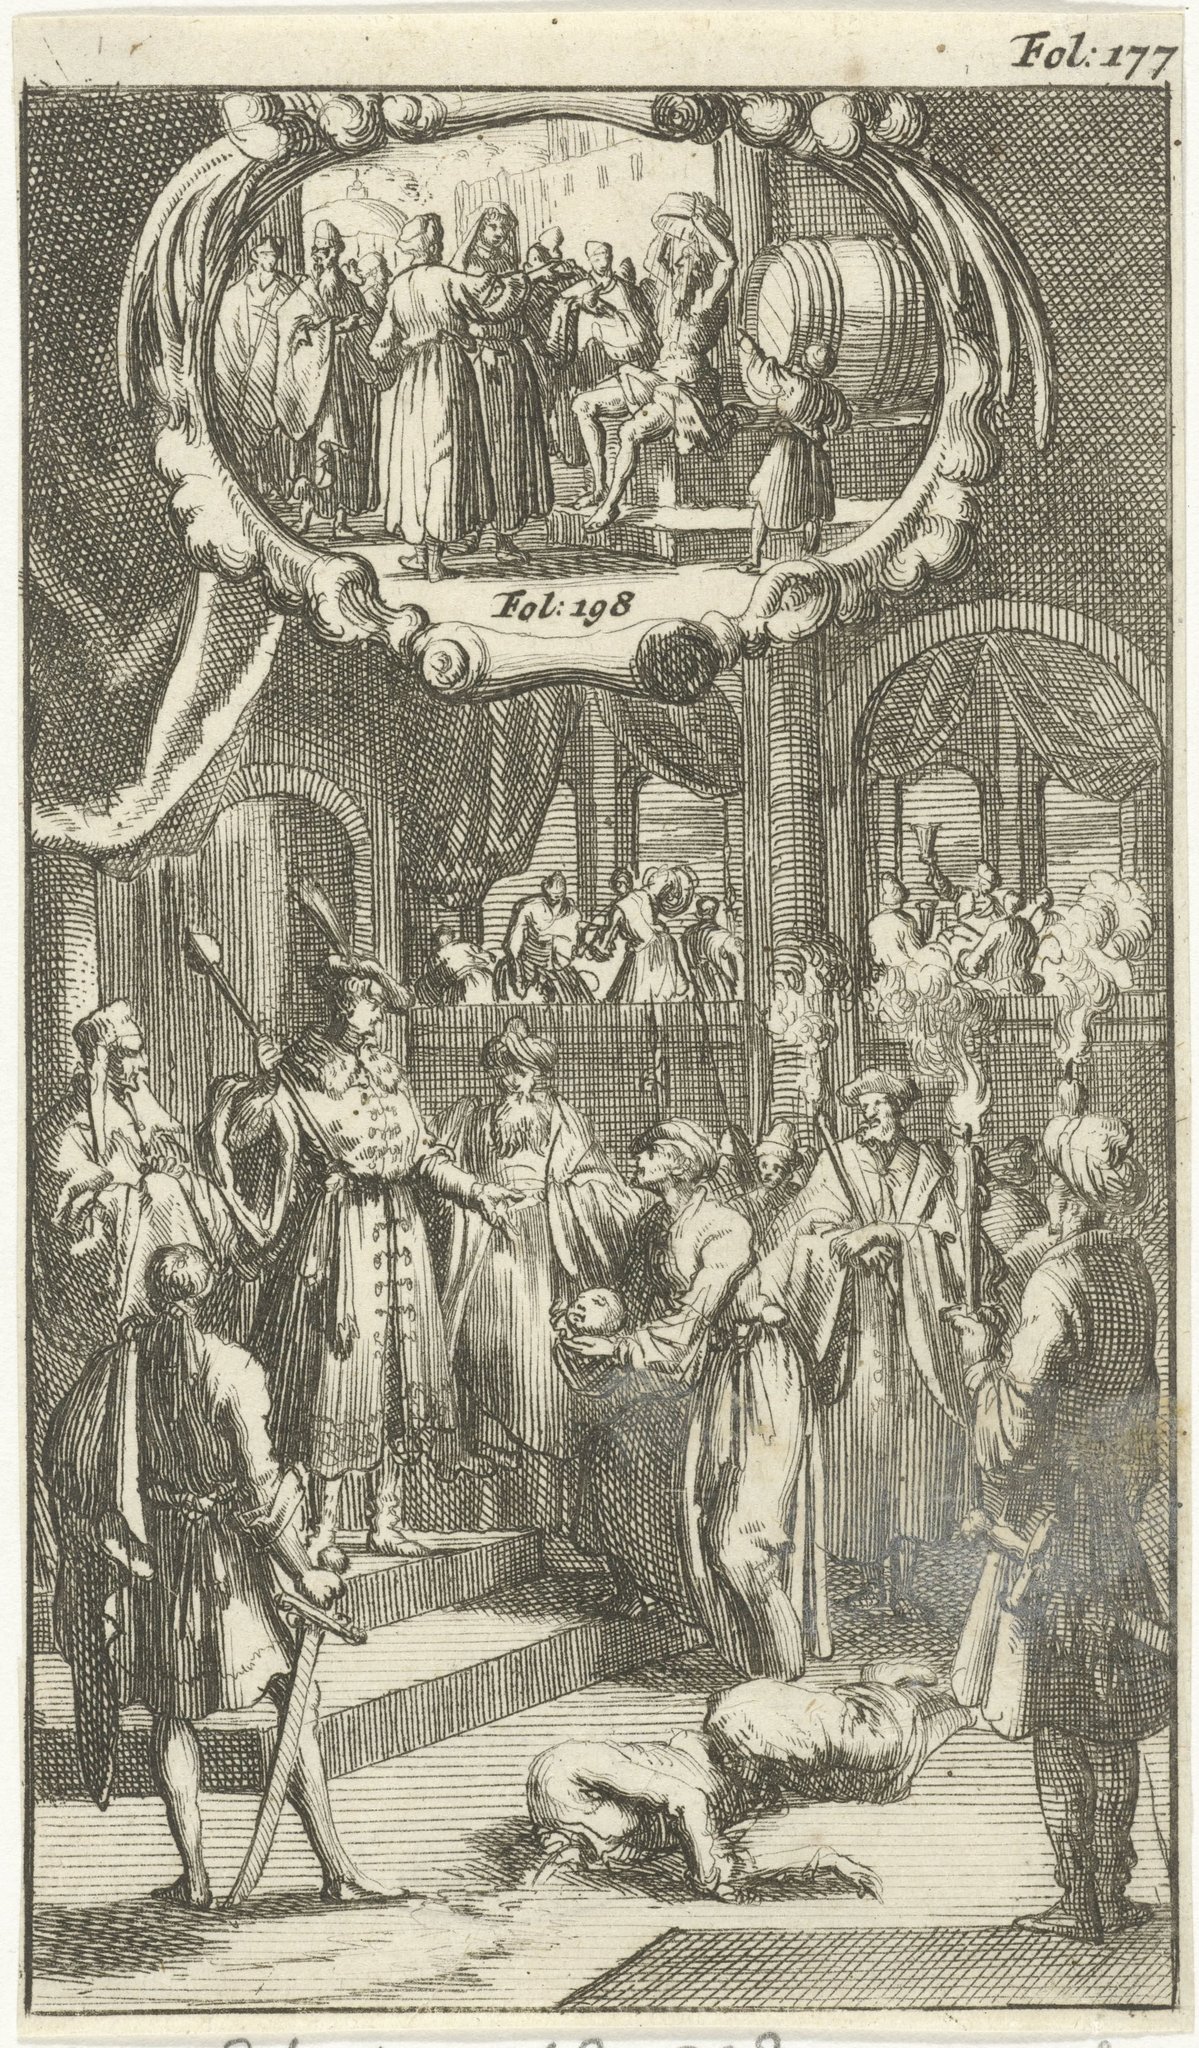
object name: book illustration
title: Nicephorus, keizer der Grieken, door de Wallachen overwonnen en onthoofd / Diogenes overgiet zich in de winter met koud water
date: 1687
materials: paper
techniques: etching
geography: amsterdam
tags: violent death by beheading, king, (story of) diogenes, the philosopher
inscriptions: collector's mark: Lugt 2228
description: Illustratie uit: Ziegler, Georg. Konst-spiegel der weereltlikke vermaken. Amsterdam: Johannes Boekholt, 1687.